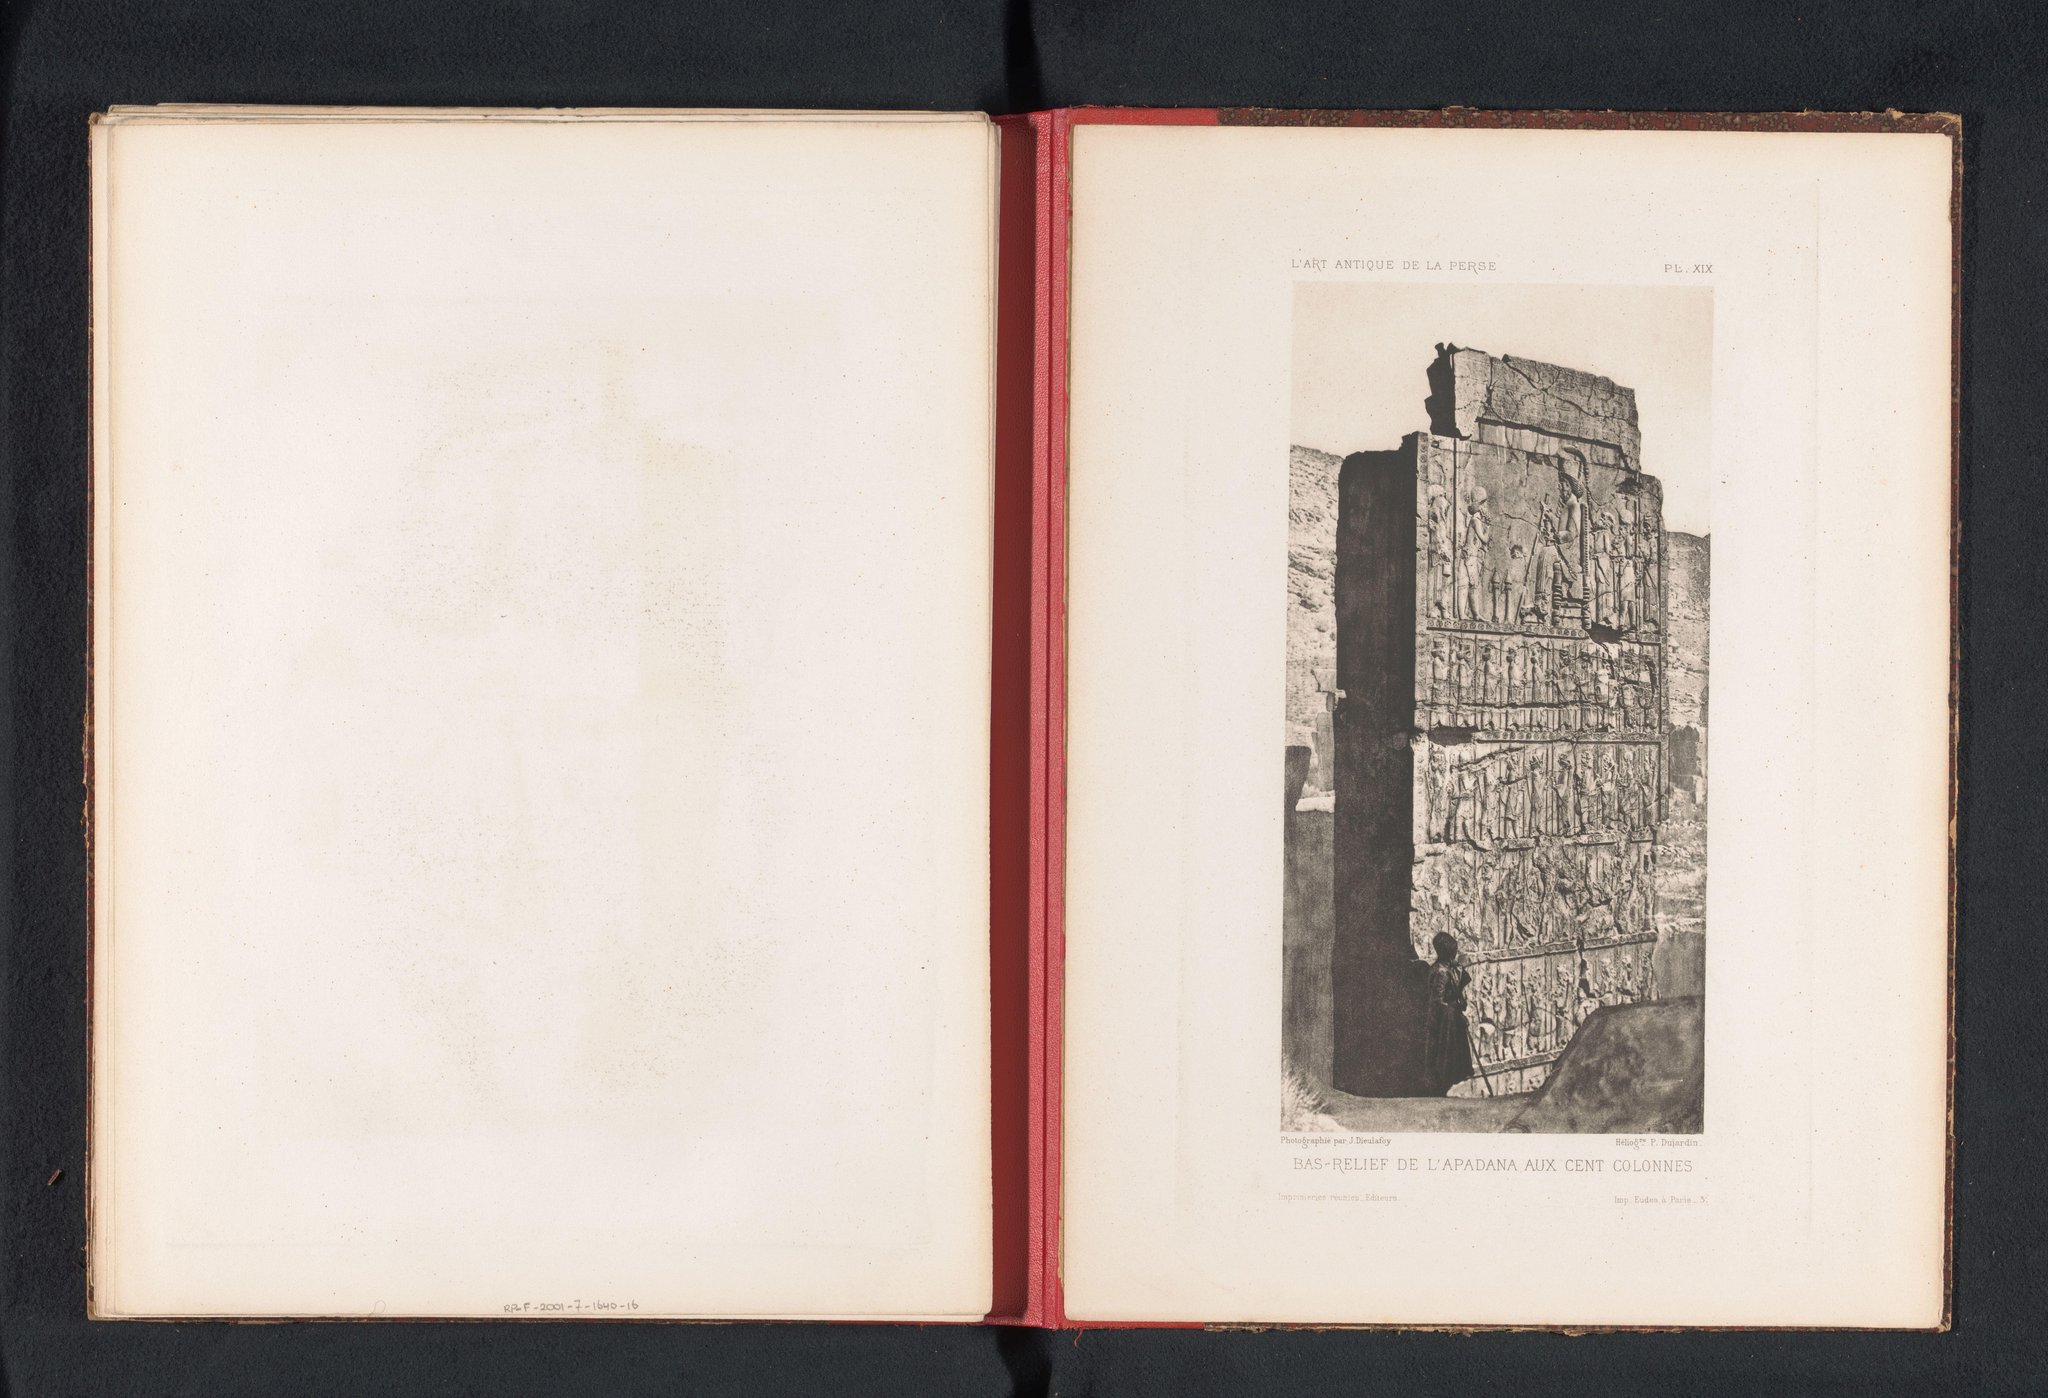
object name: photomechanical print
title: Reliëf van een apadana in Persepolis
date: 1880-1885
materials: paper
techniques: photoaquatint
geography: paris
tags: sculpture (+ relief ~ sculpture)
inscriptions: number: ‘PL. XIX’, inscription: ‘Imprimeries réunies_Editeurs. Imp. Eudes, à Paris_3.’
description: Deze prent maakt deel uit van een omslag met twintig prenten op zeventien bladen en vijftien tekstbladen.